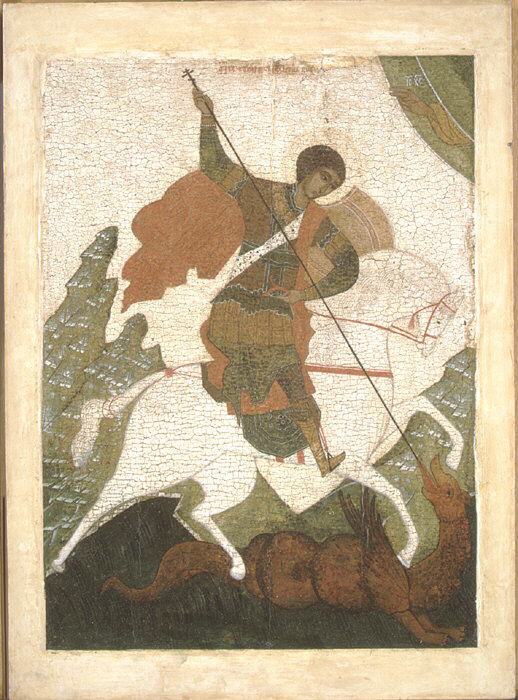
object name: painting, icon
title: Saint George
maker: russian painter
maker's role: artist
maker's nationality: russian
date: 1500-1599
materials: paint, wood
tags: dragons,horses,saint george